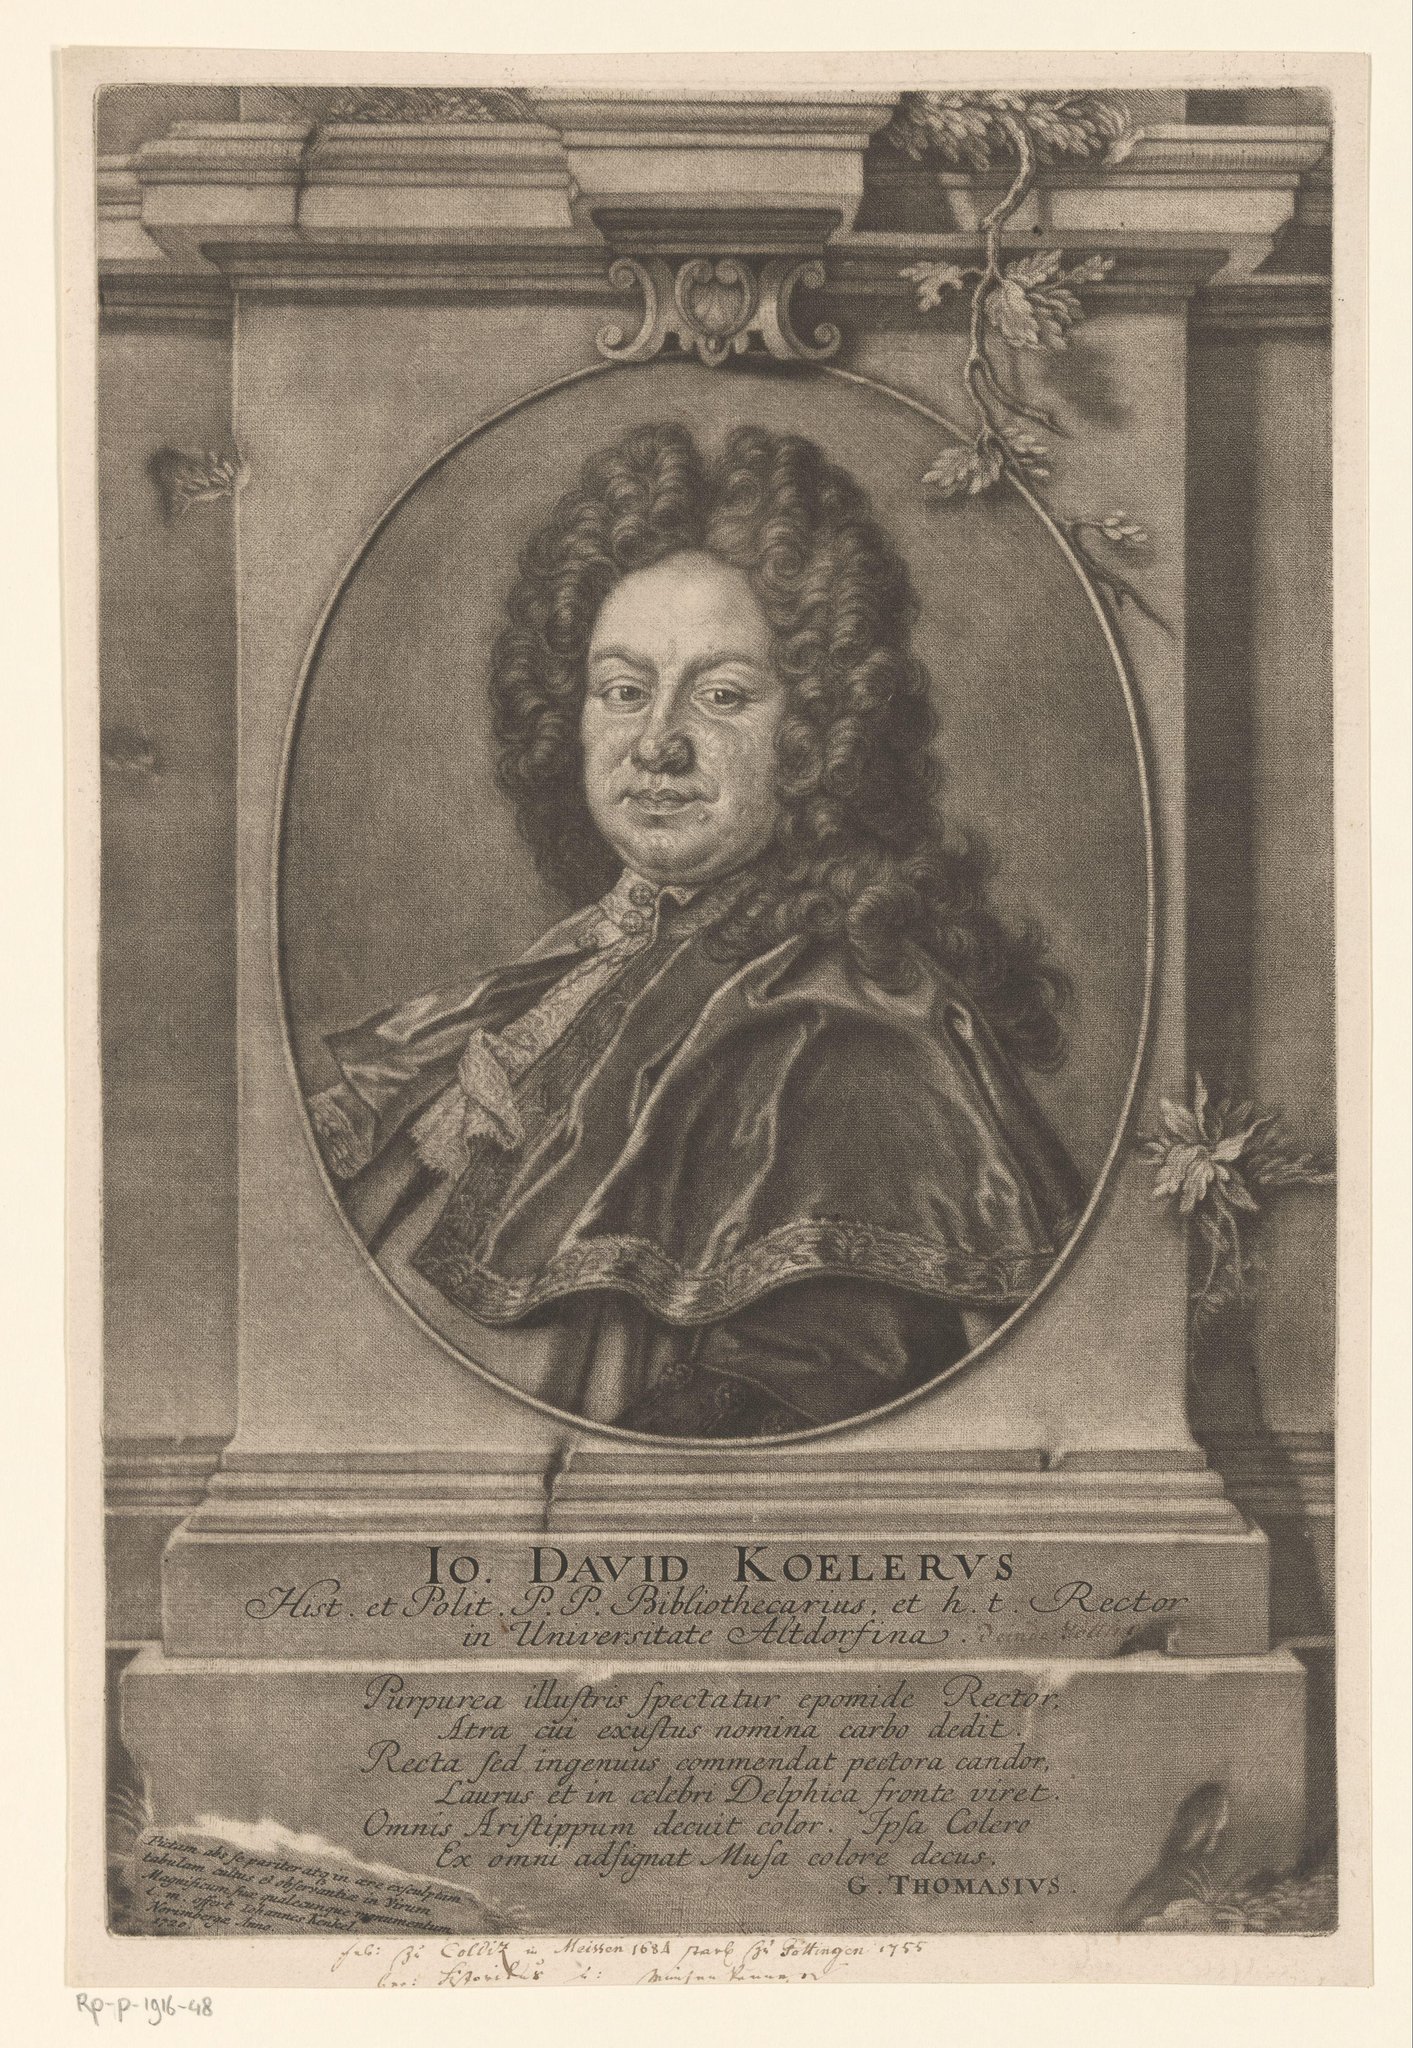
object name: print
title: Portret van Johann David Köhler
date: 1720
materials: paper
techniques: mezzotint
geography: nuremberg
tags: plants; vegetation, ornament ~ medallion, historical persons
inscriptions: collector's mark: Lugt 9, collector's mark: Lugt 2228, inscription